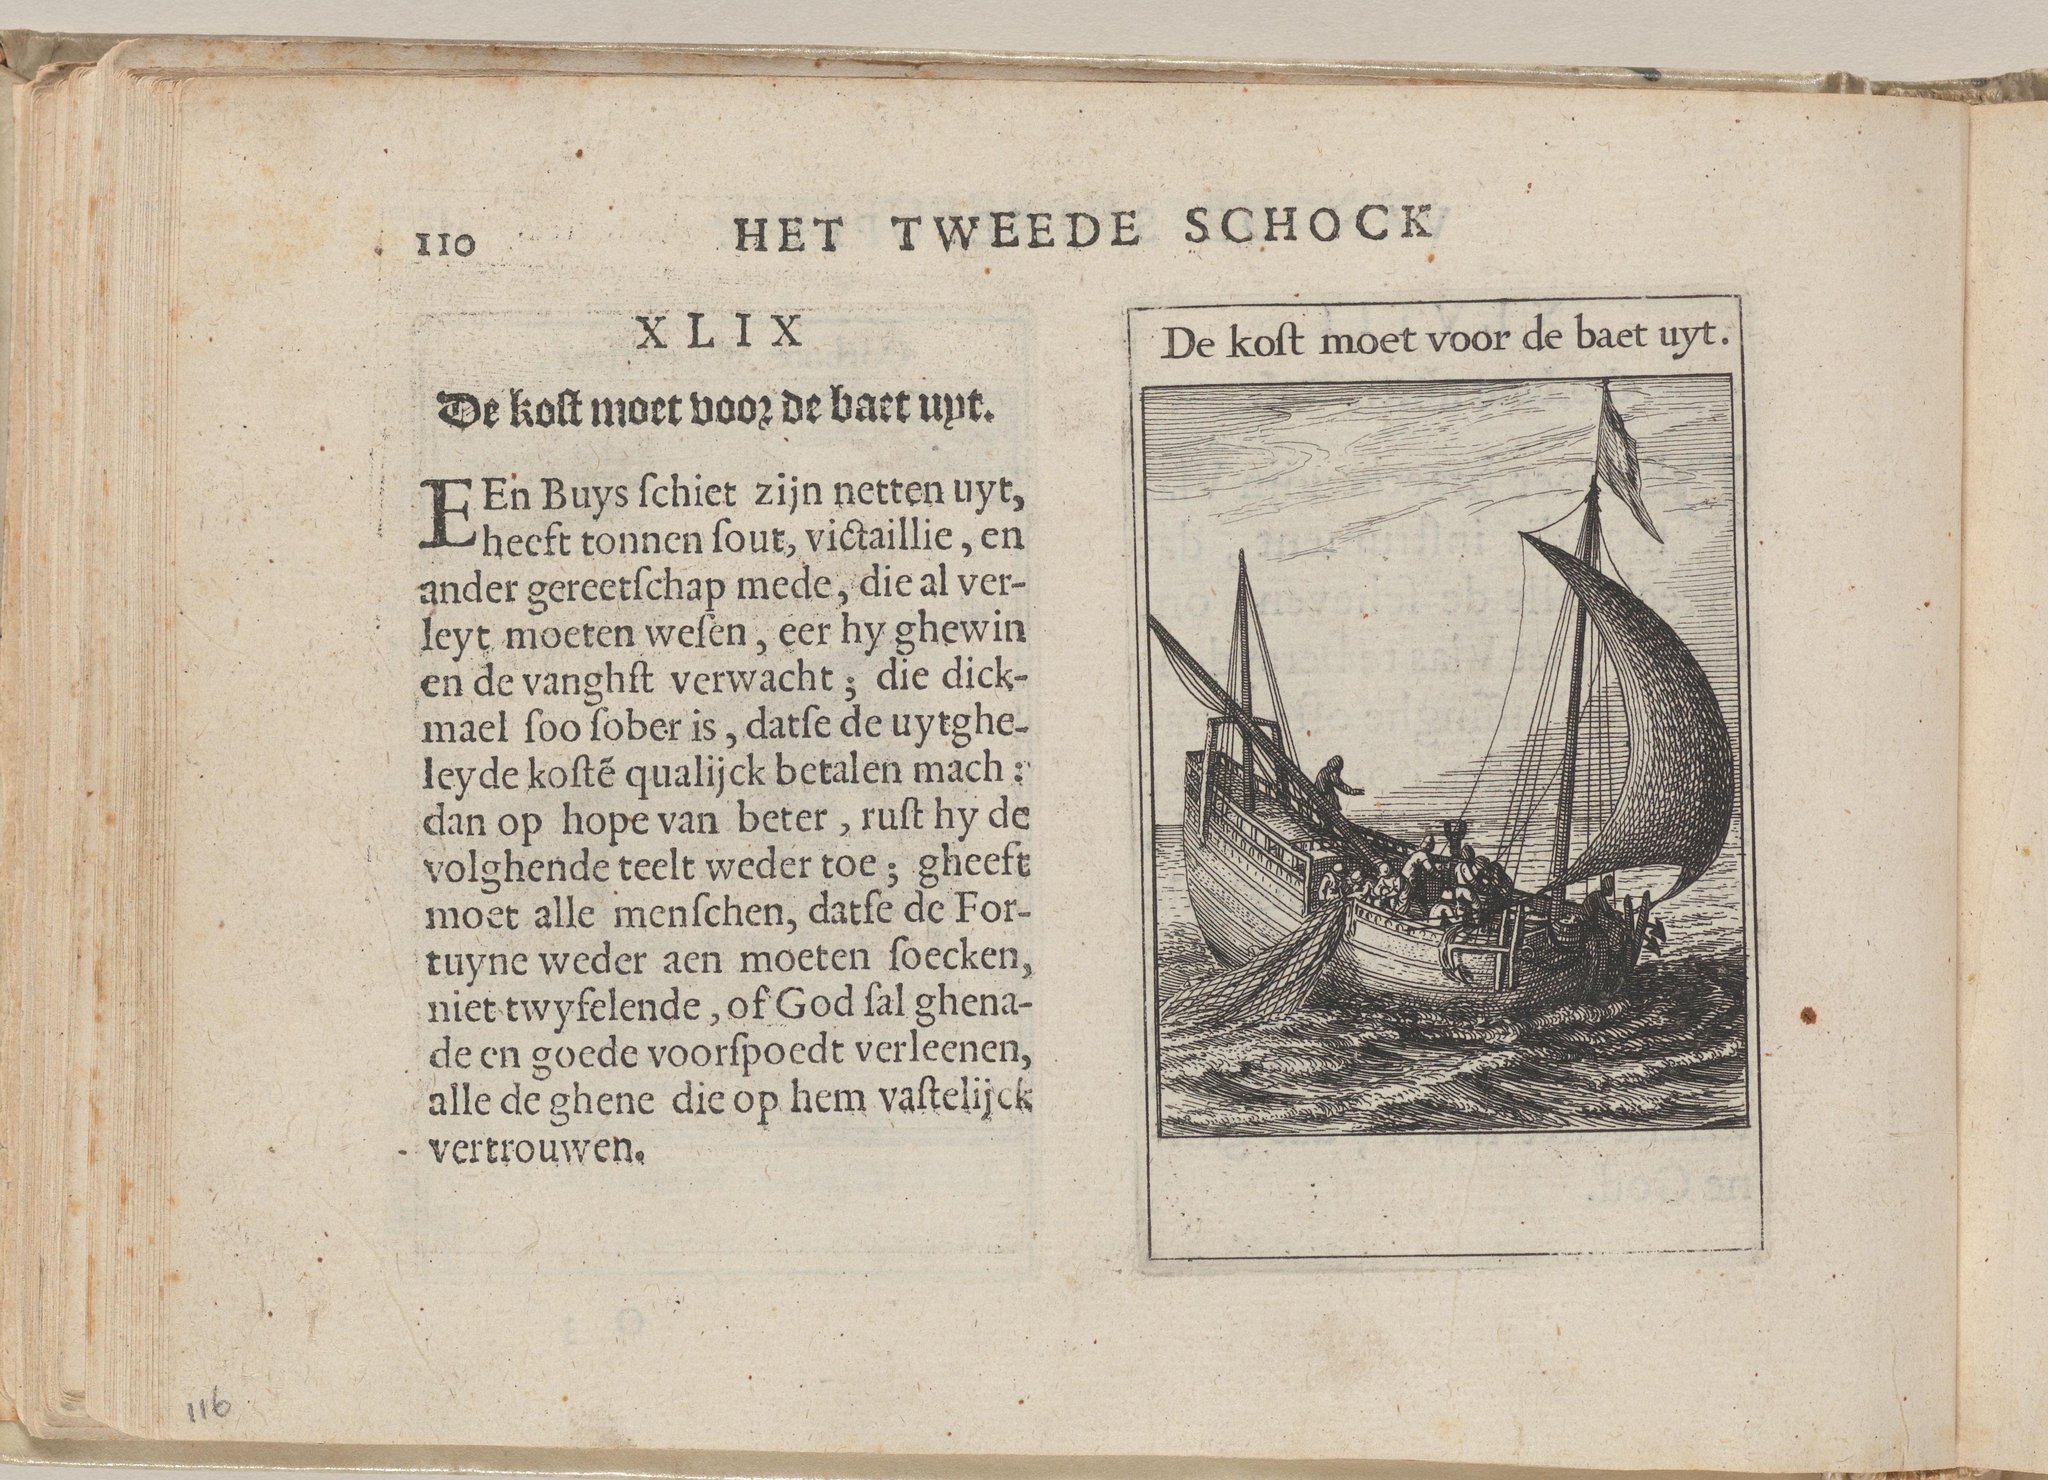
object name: print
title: XLIX De kost moet voor de baet uyt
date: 1614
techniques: engraving, printing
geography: amsterdam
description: XLIX De kost moet voor de baet uyt. Tweede schok. Onderdeel van 'Sinnepoppen', R. Visscher, 1614.